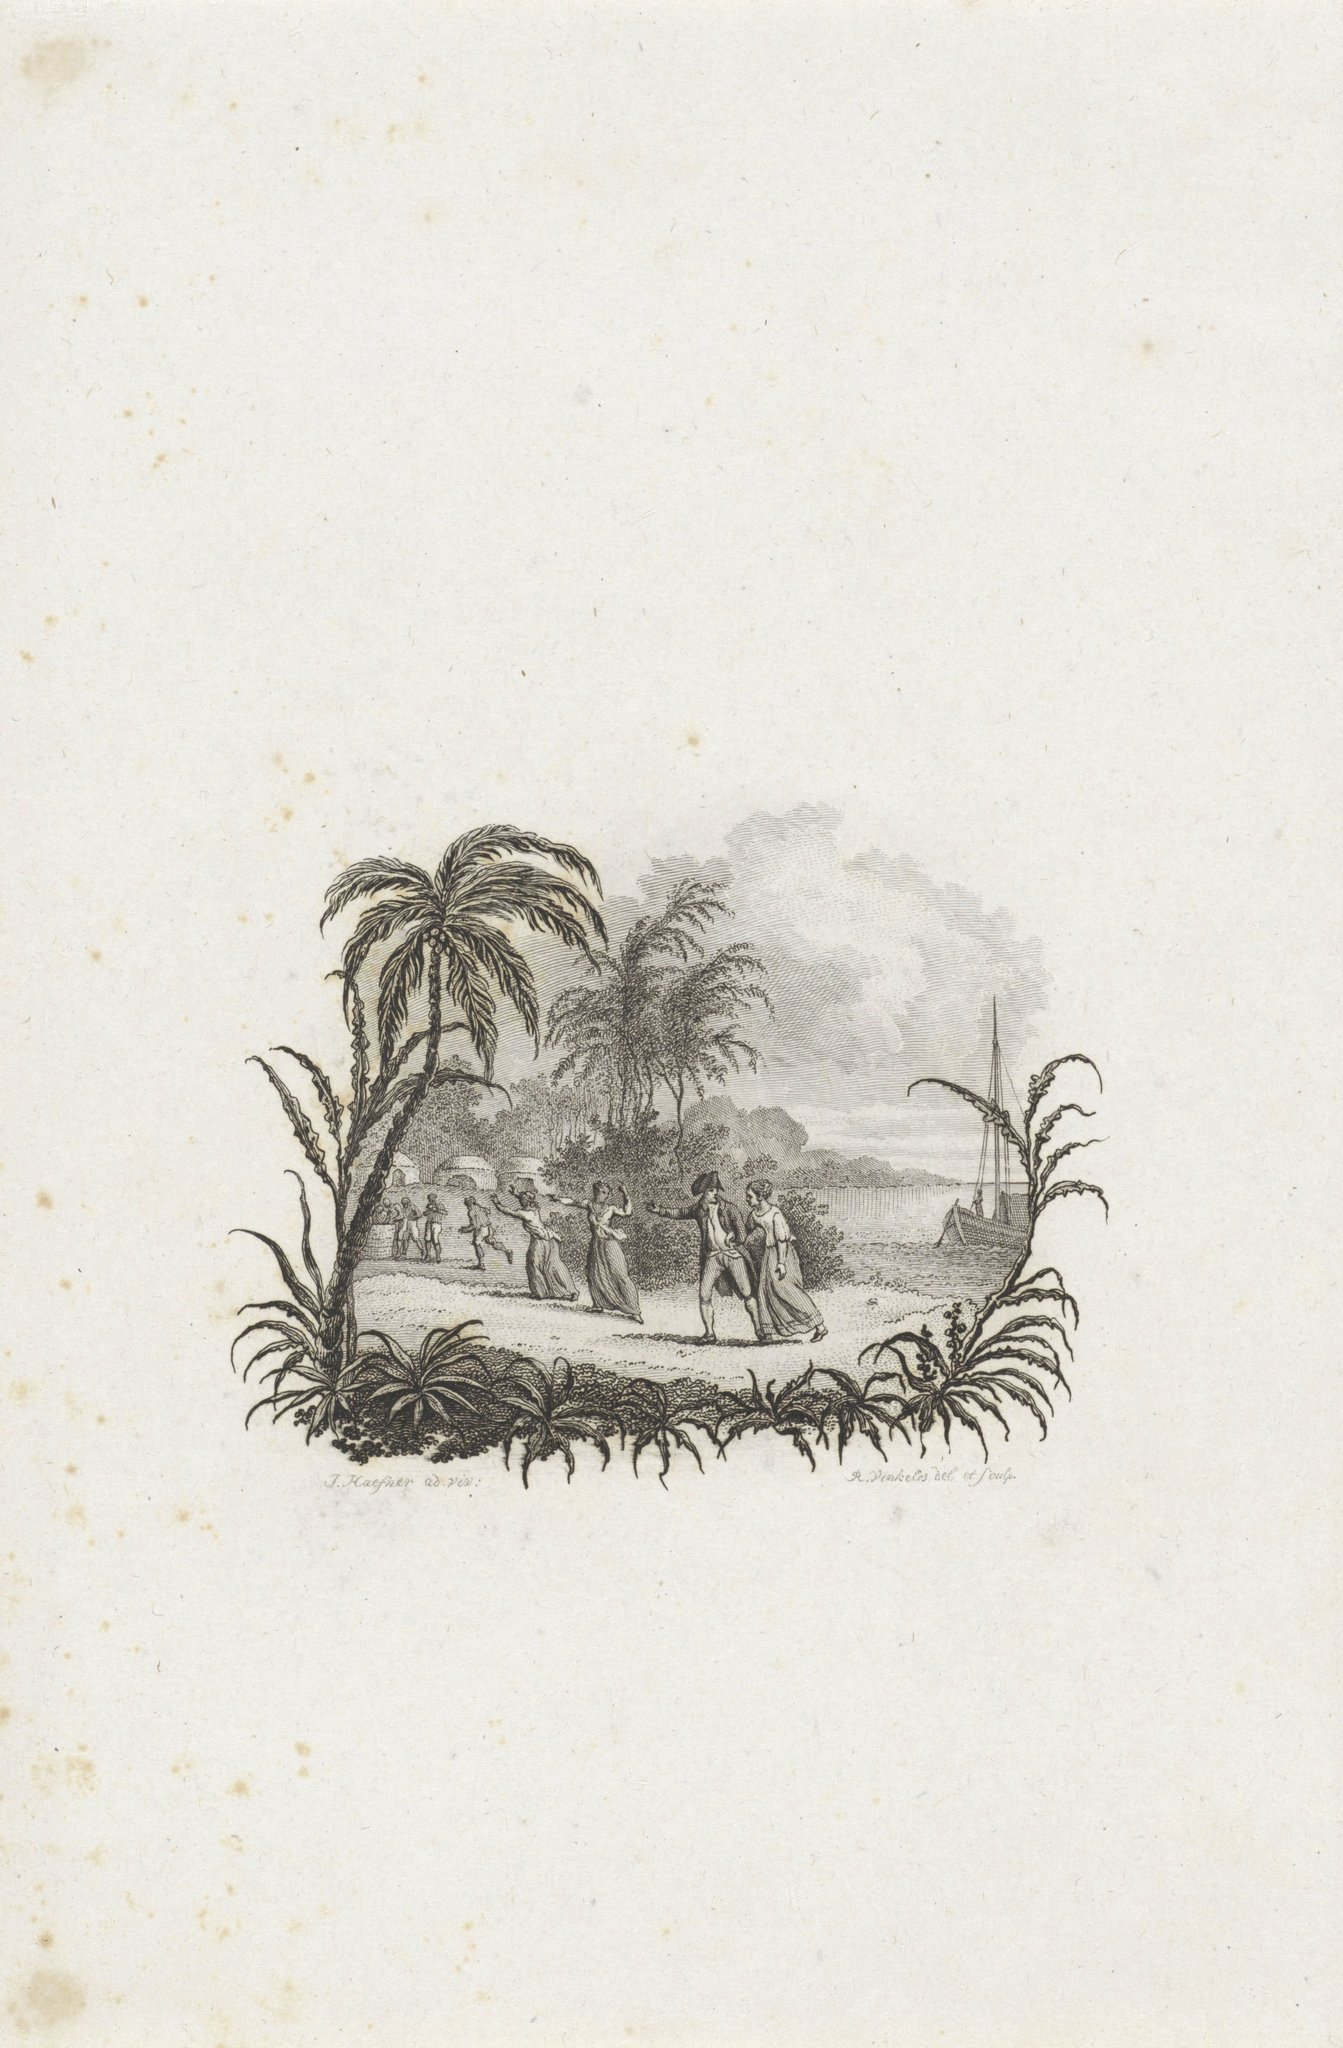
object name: print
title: Europeanen aan een kust van een Zuidoost-Aziatisch land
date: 1806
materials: paper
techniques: engraving, etching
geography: amsterdam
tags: asiatic races and peoples, island (in tropical and sub-tropical regions), sri lanka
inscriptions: collector's mark: Lugt 240, collector's mark: Lugt 2228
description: Latere staat gebruikt als titelpagina voor: Haafner, Jacob Godfried. Lotgevallen op eene reize van Madras over Tranquebaar naar het eiland Ceilon. Haarlem: A. Loosjes, 1806.